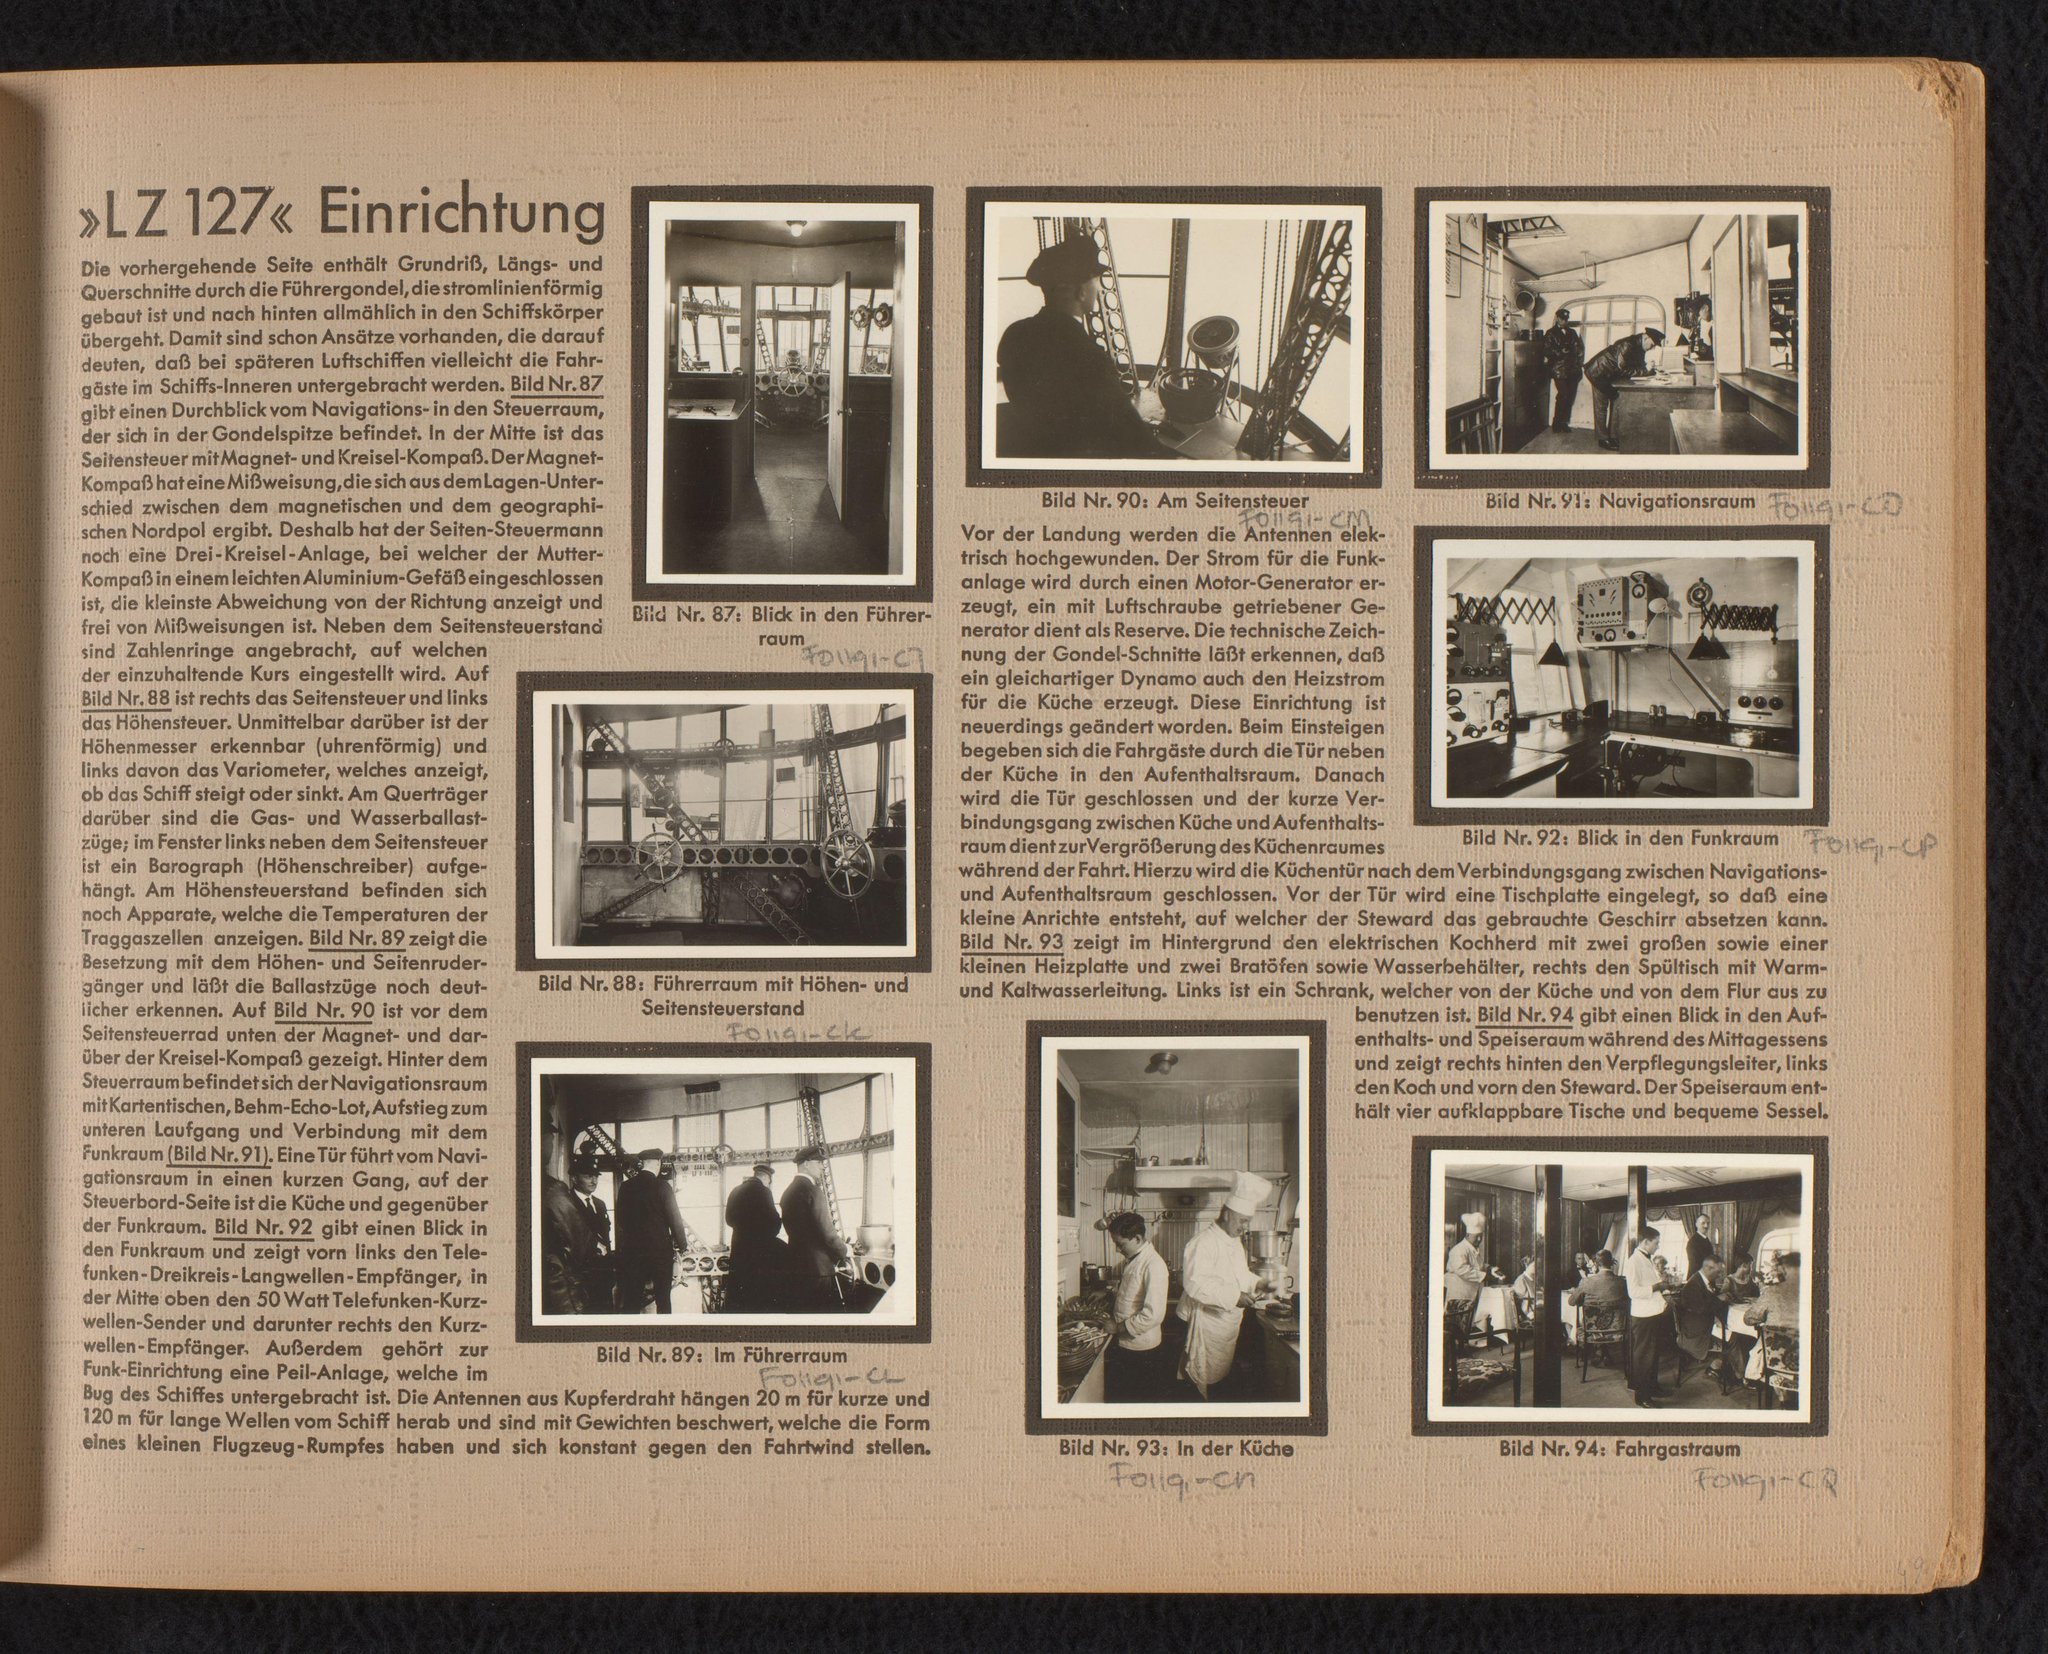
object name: album leaf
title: Vertrekken in LZ127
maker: Anonymous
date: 1928-1938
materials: paper, photographic support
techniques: gelatin silver print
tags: kitchen, radio, wireless, radio broadcasting, airship, zeppelin (+ view ~ vehicle, ship, etc.), germany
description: Acht foto's van verschillende vertrekken in zeppelin LZ127, waaronder de keuken en de radio- en navigeerkamer. Alle foto's zijn voorzien van een nummer en titel. Deze pagina maakt deel uit van een album.